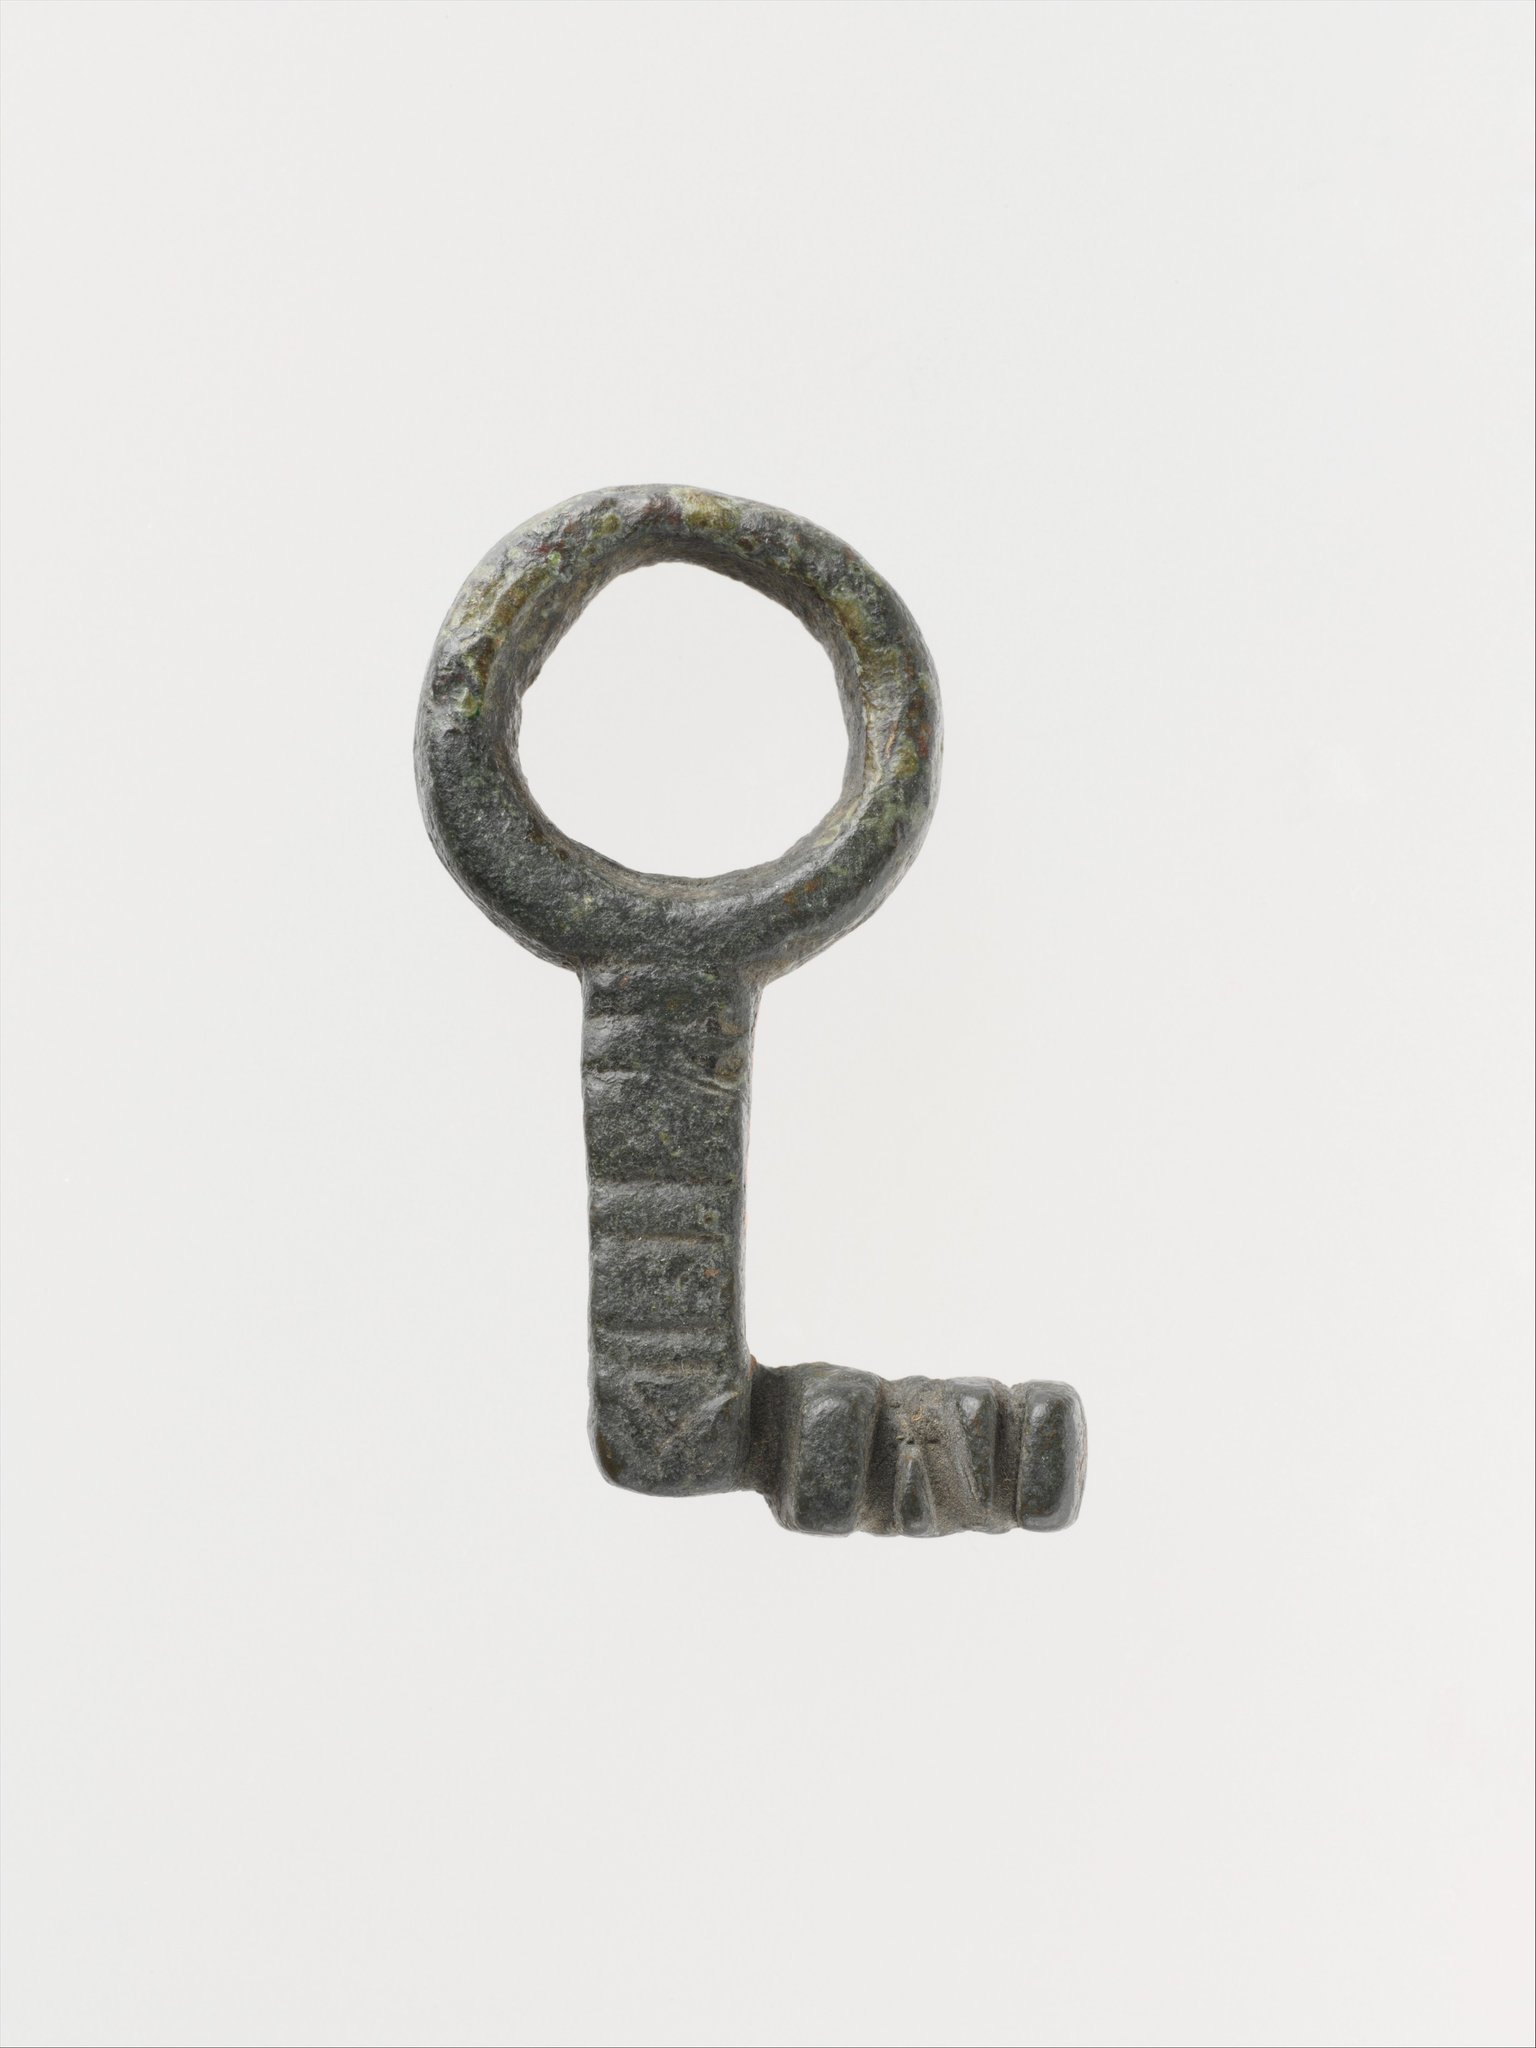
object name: key ring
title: Bronze ring key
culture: roman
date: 201-400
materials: bronze